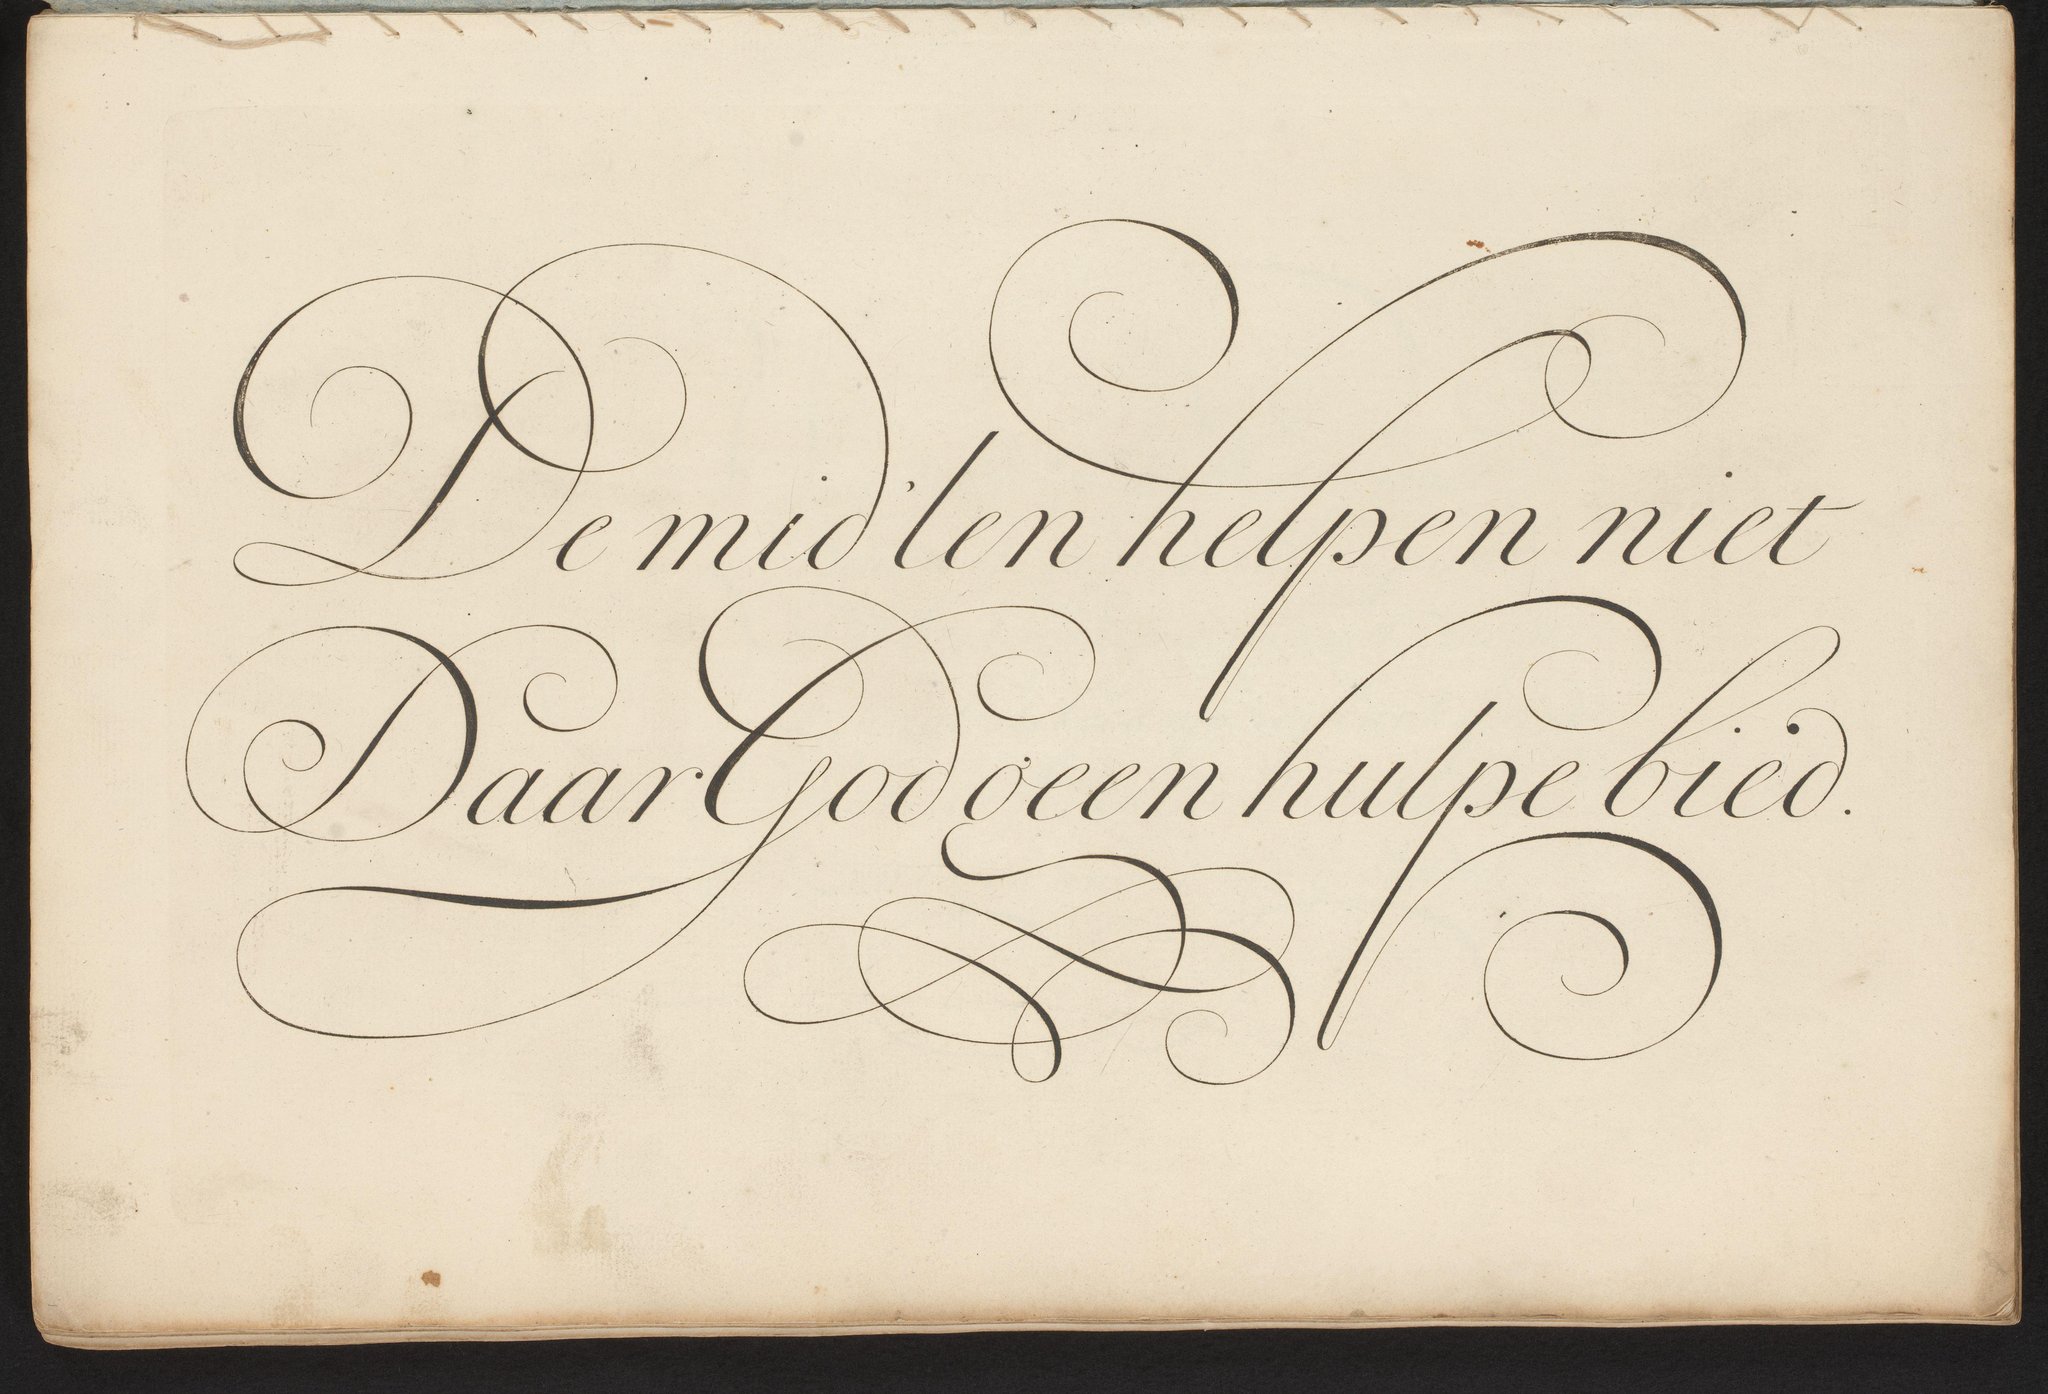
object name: album leaf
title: Schrijfvoorbeeld: De mid'len helpen niet (...)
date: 1660-1751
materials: paper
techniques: engraving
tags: calligraphy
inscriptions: collector's mark: ‘Ronde stempel met wapen van Utrecht en daaromheen de tekst: School voor de Grafische Vakken te Utrecht’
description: Schrijfvoorbeeld met twee regels tekst in het Nederlands: De mid'len helpen niet ... De prent maakt deel uit van een album